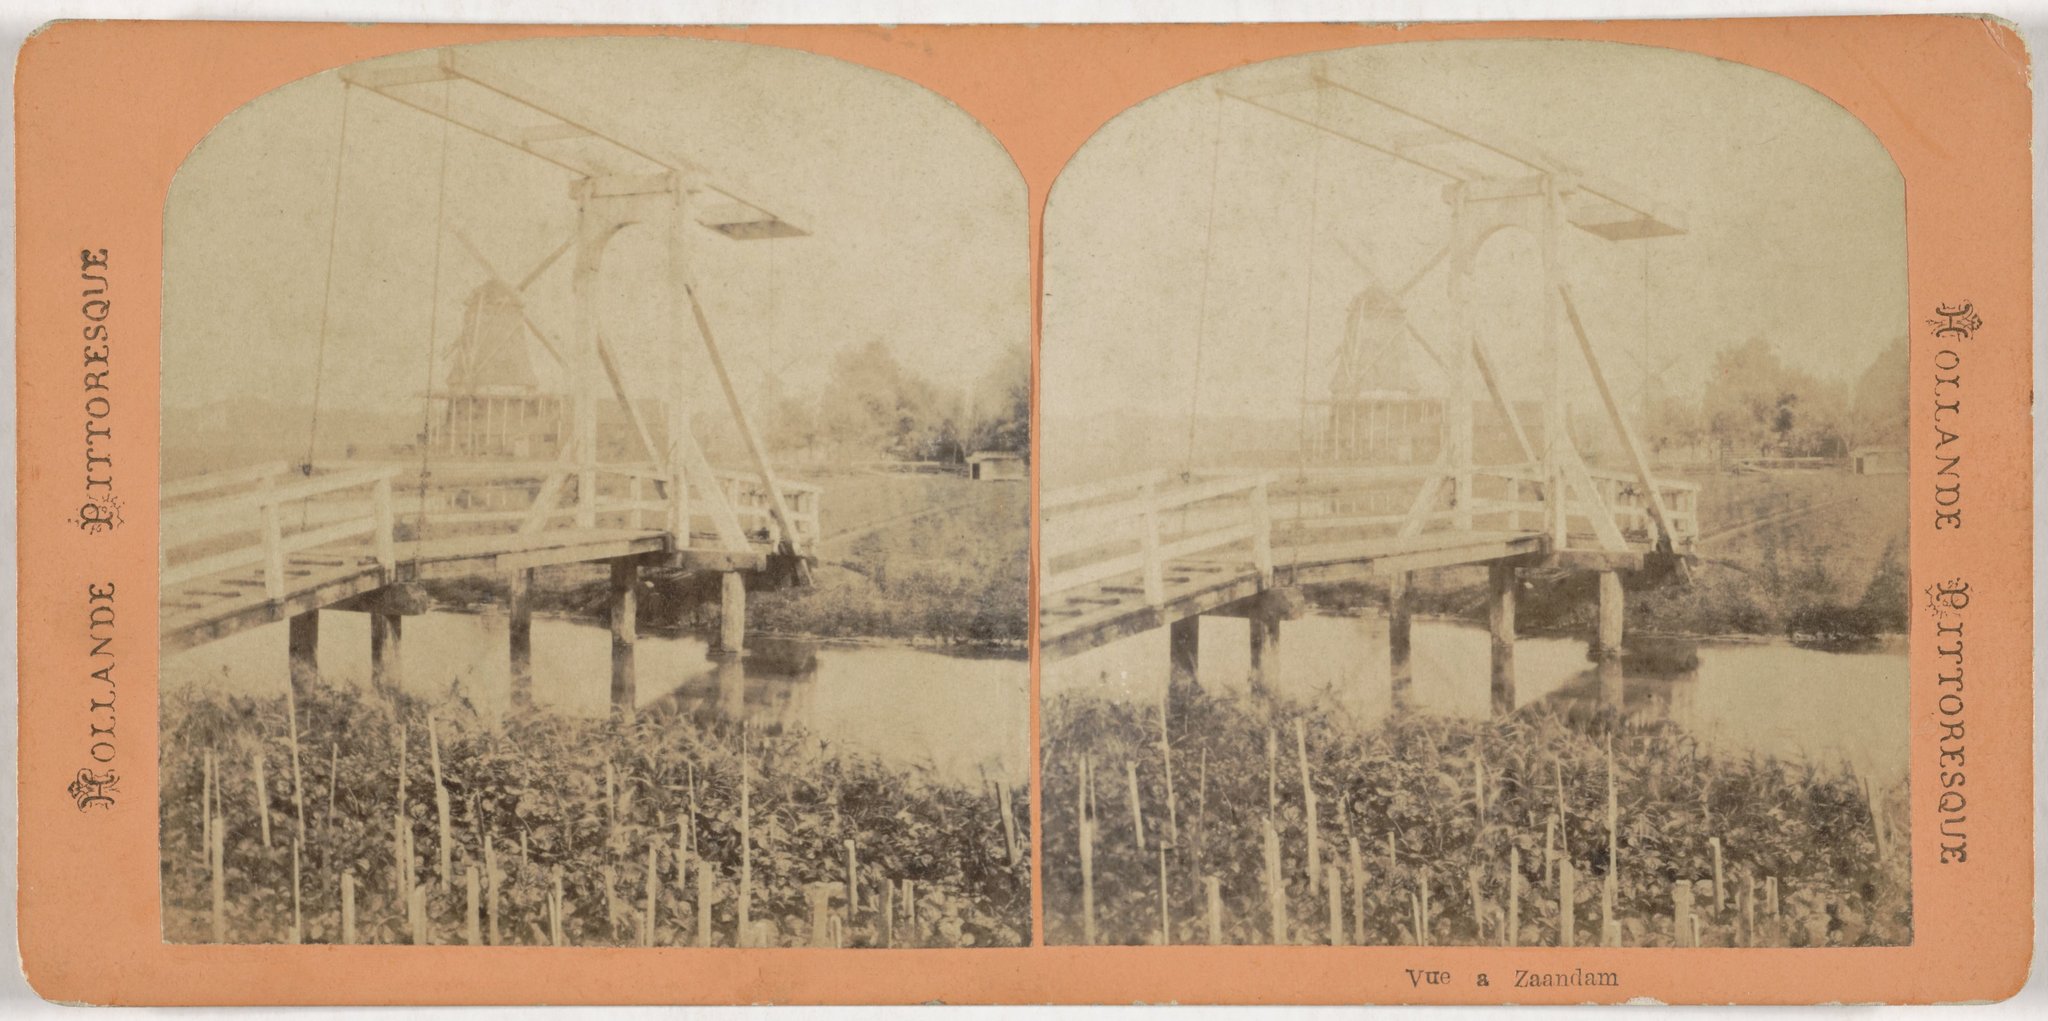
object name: stereograph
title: Vue a Zaandam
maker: Anonymous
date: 1873-1890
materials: cardboard, paper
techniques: albumen print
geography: zaandam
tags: windmill in landscape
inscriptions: inscription: ‘40’